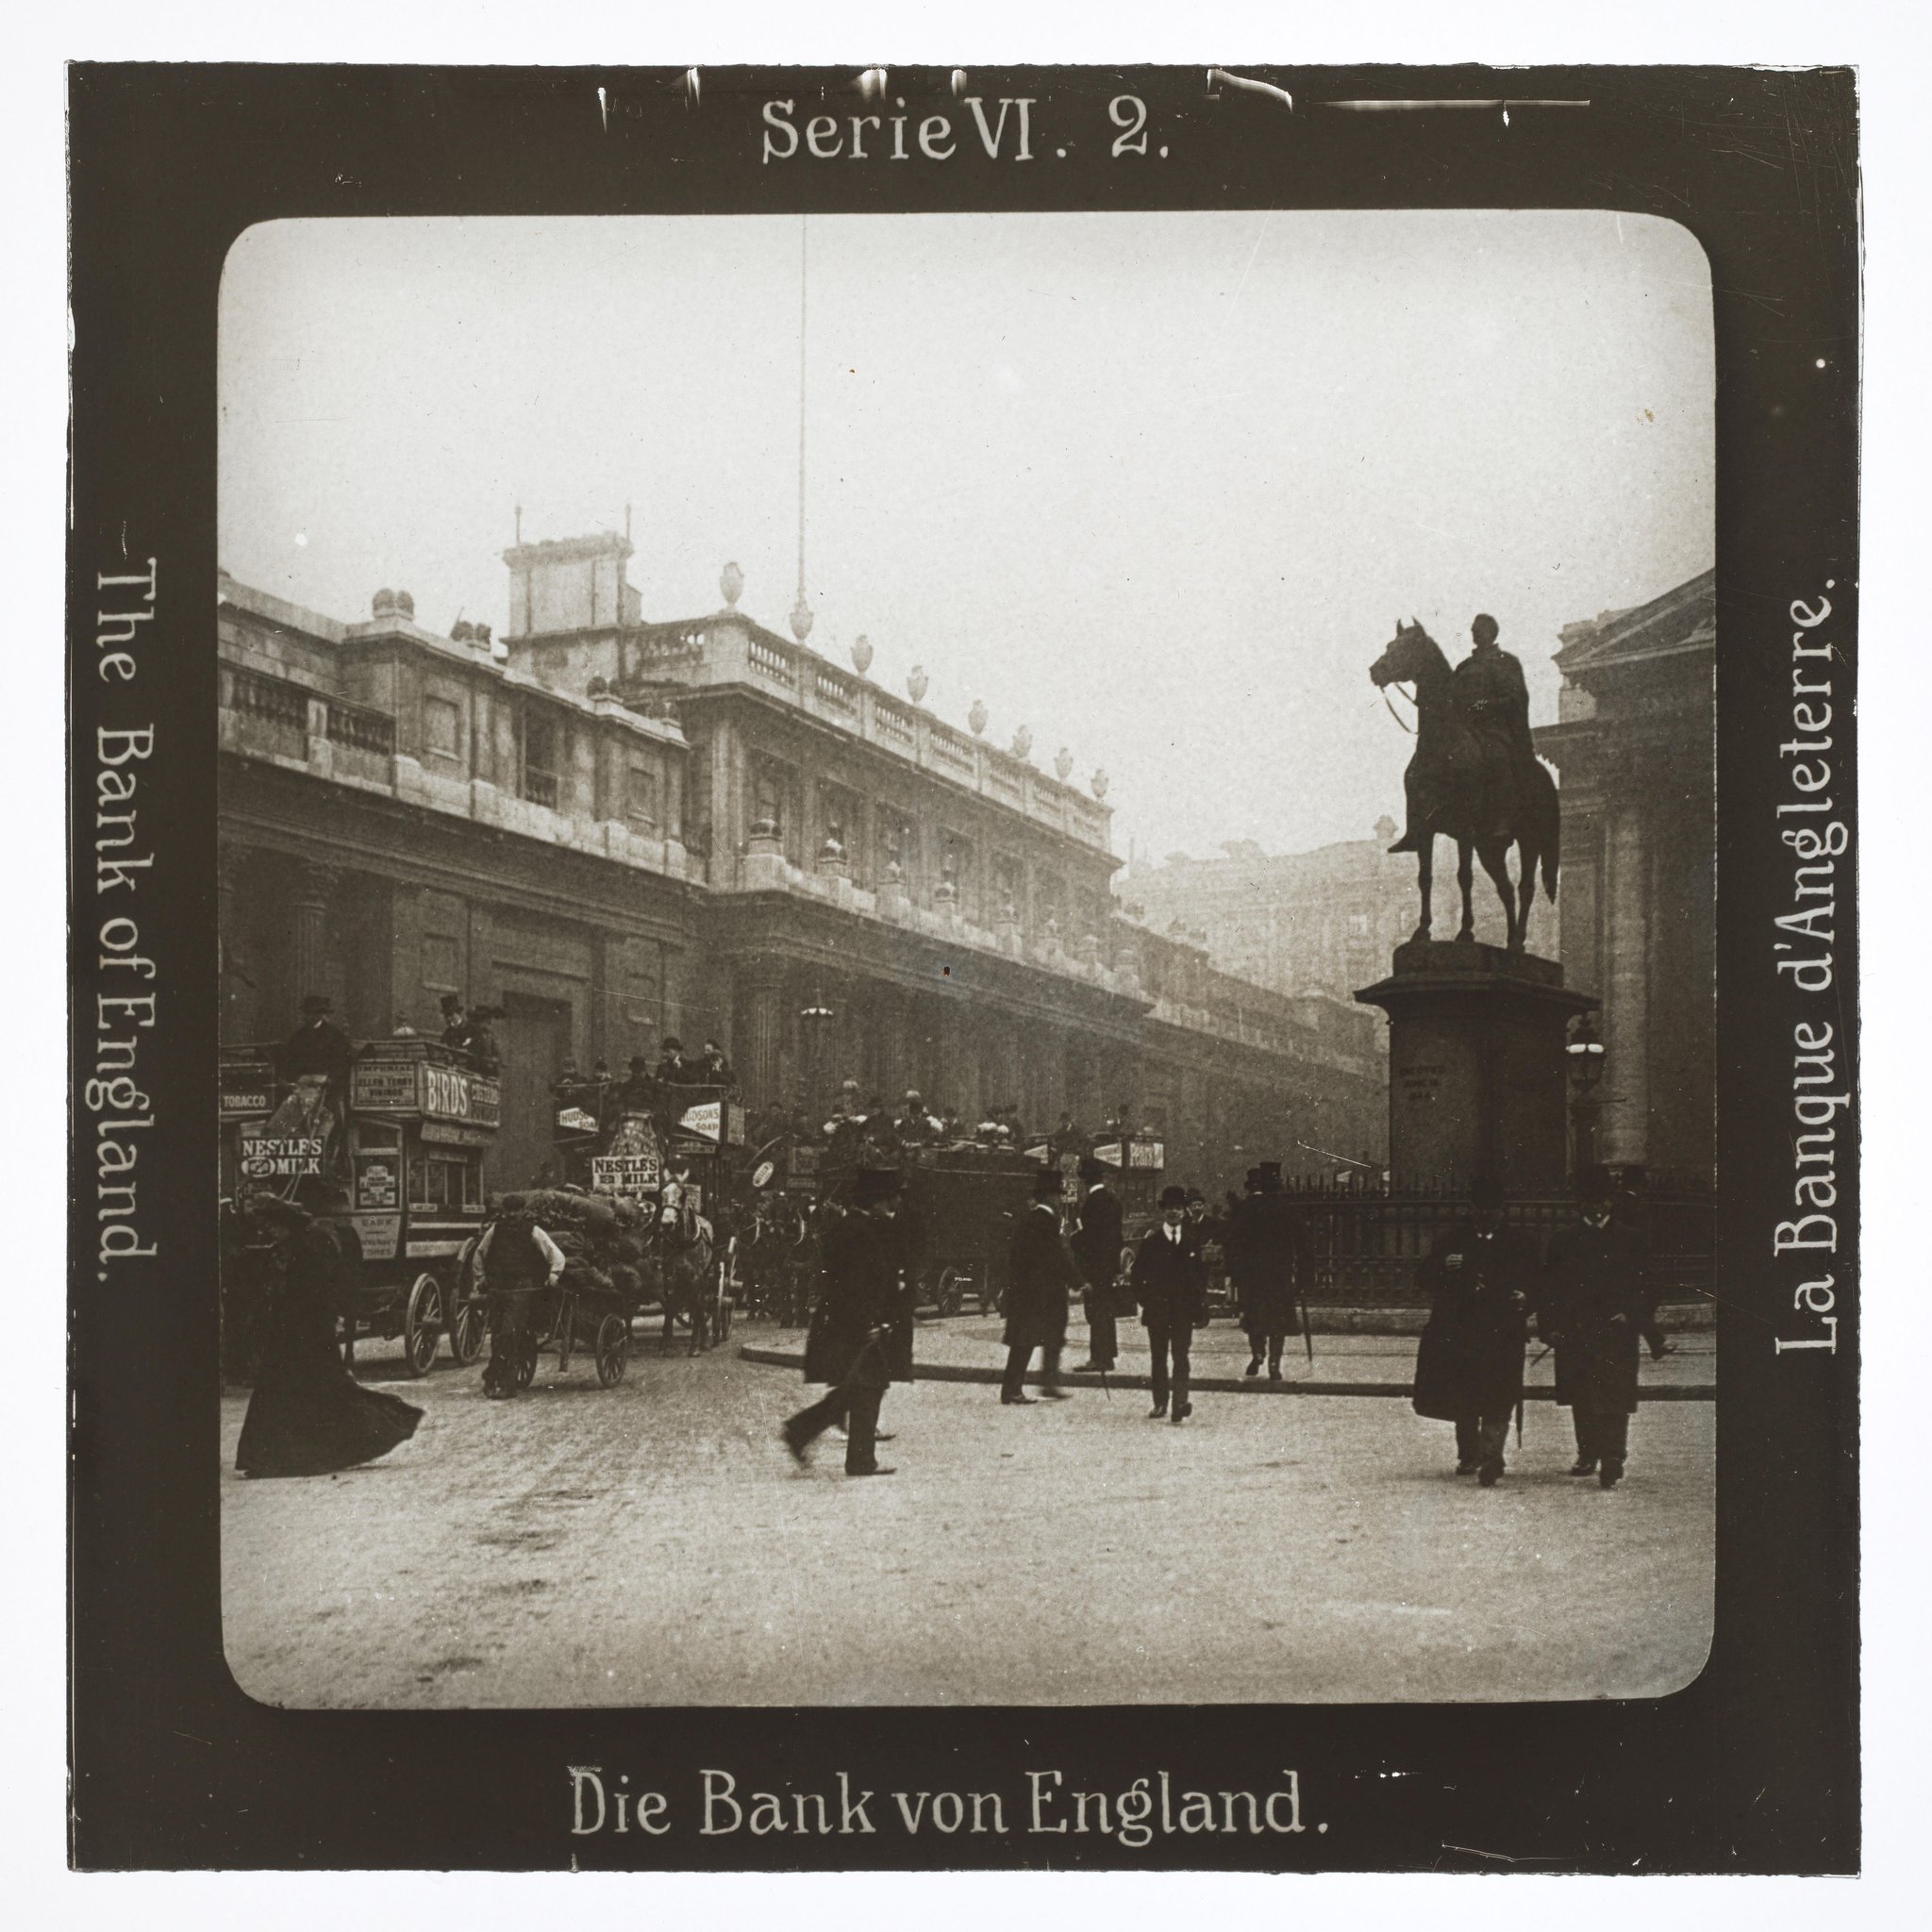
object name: lantern slide photographic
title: Gezicht op de Bank of England en het ruiterstandbeeld van de Duke of Wellington te Londen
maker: Anonymous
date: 1900-1906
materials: glass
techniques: gelatin silver transparency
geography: london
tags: monument, statue, façade (of house or building), bank